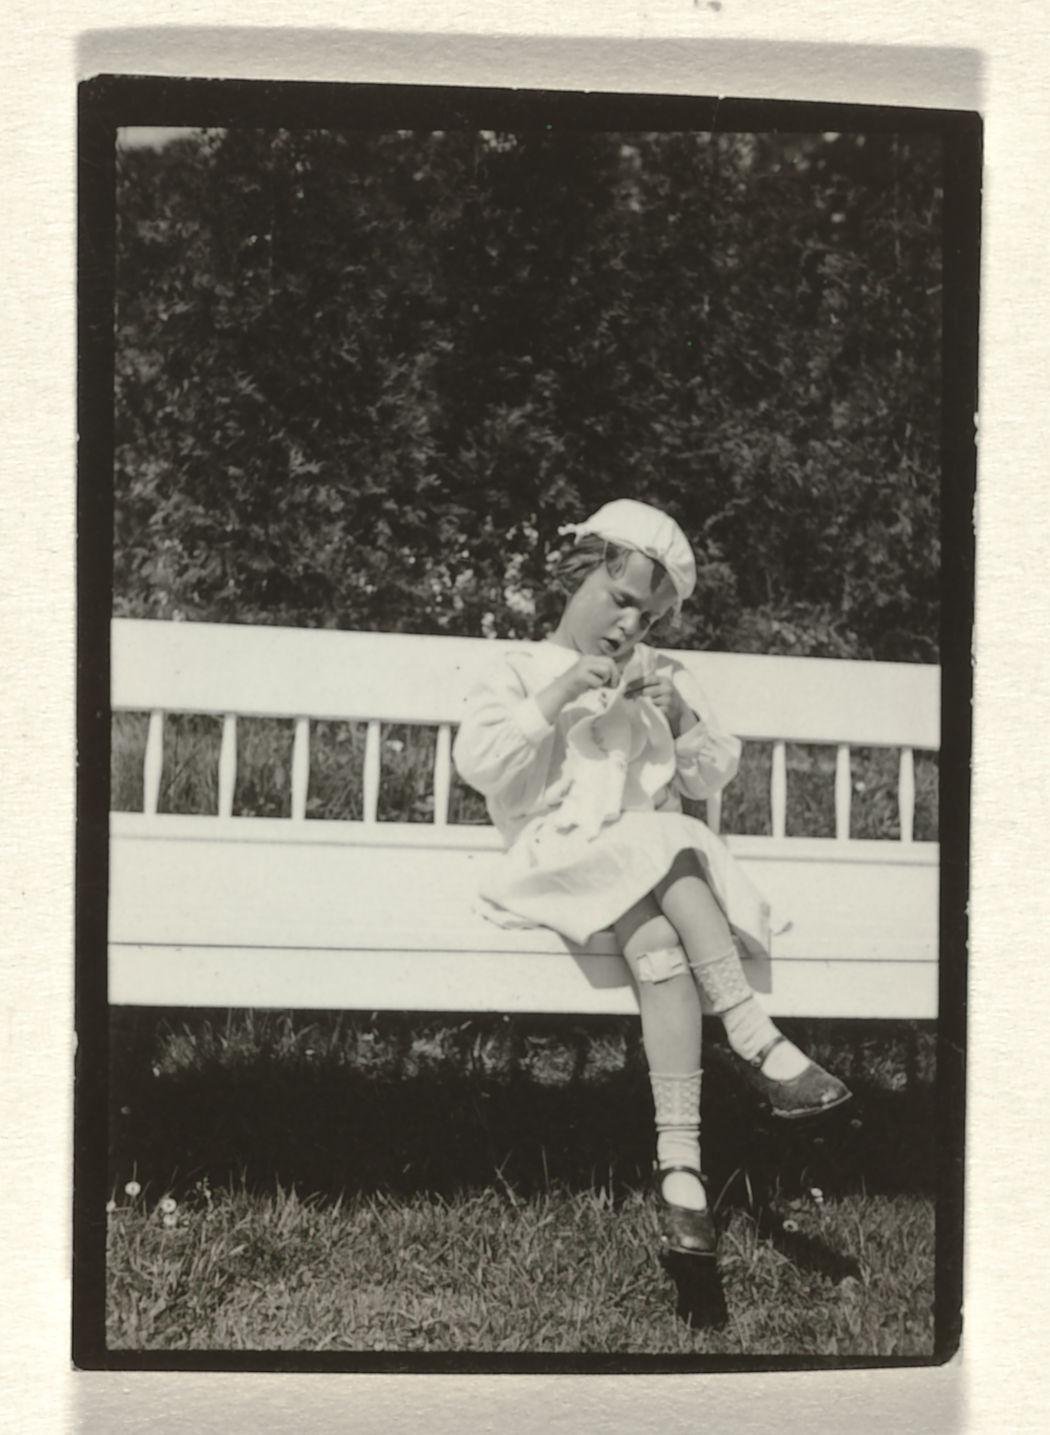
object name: photograph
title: Isabel Wachenheimer leert veters strikken op een bankje in Baden-Baden, april 1933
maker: oskar hirrlinger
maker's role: fotograaf, fotohandel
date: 1904-1933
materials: photographic support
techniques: gelatin silver print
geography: baden-baden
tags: leiden, isabel wachenheimer-elon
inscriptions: date: ‘B.-Bad., April 1933. Sie lernt stricken!’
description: Dit object is onderdeel van de nalatenschap van Isabel Elon-Wachenheimer (1928-2010). Tot haar overlijden behoorde het samen met de andere objecten uit de nalatenschap tot haar privédomein van Isabel Wachenheimer. In die particuliere context zijn deze objecten tezamen en individueel aandenkens - aan de jeugd, ouders en familie van Isabel Wachenheimer vóór en tijdens de Shoah en aan haar leven na de Tweede Wereldoorlog. Isabel Wachenheimer, die van juni 1943 tot mei 1945 gevangen zat in Kamp Westerbork, Theresienstadt, Auschwitz, Lenzing a/d Oberdonau (een buitenkamp van Mauthausen), overleefde de Shoah. Haar ouders – Eugène Wachenheimer en Else Wachenheimer-Moos - werden op 14 oktober 1944 in Auschwitz-Birkenau vermoord.